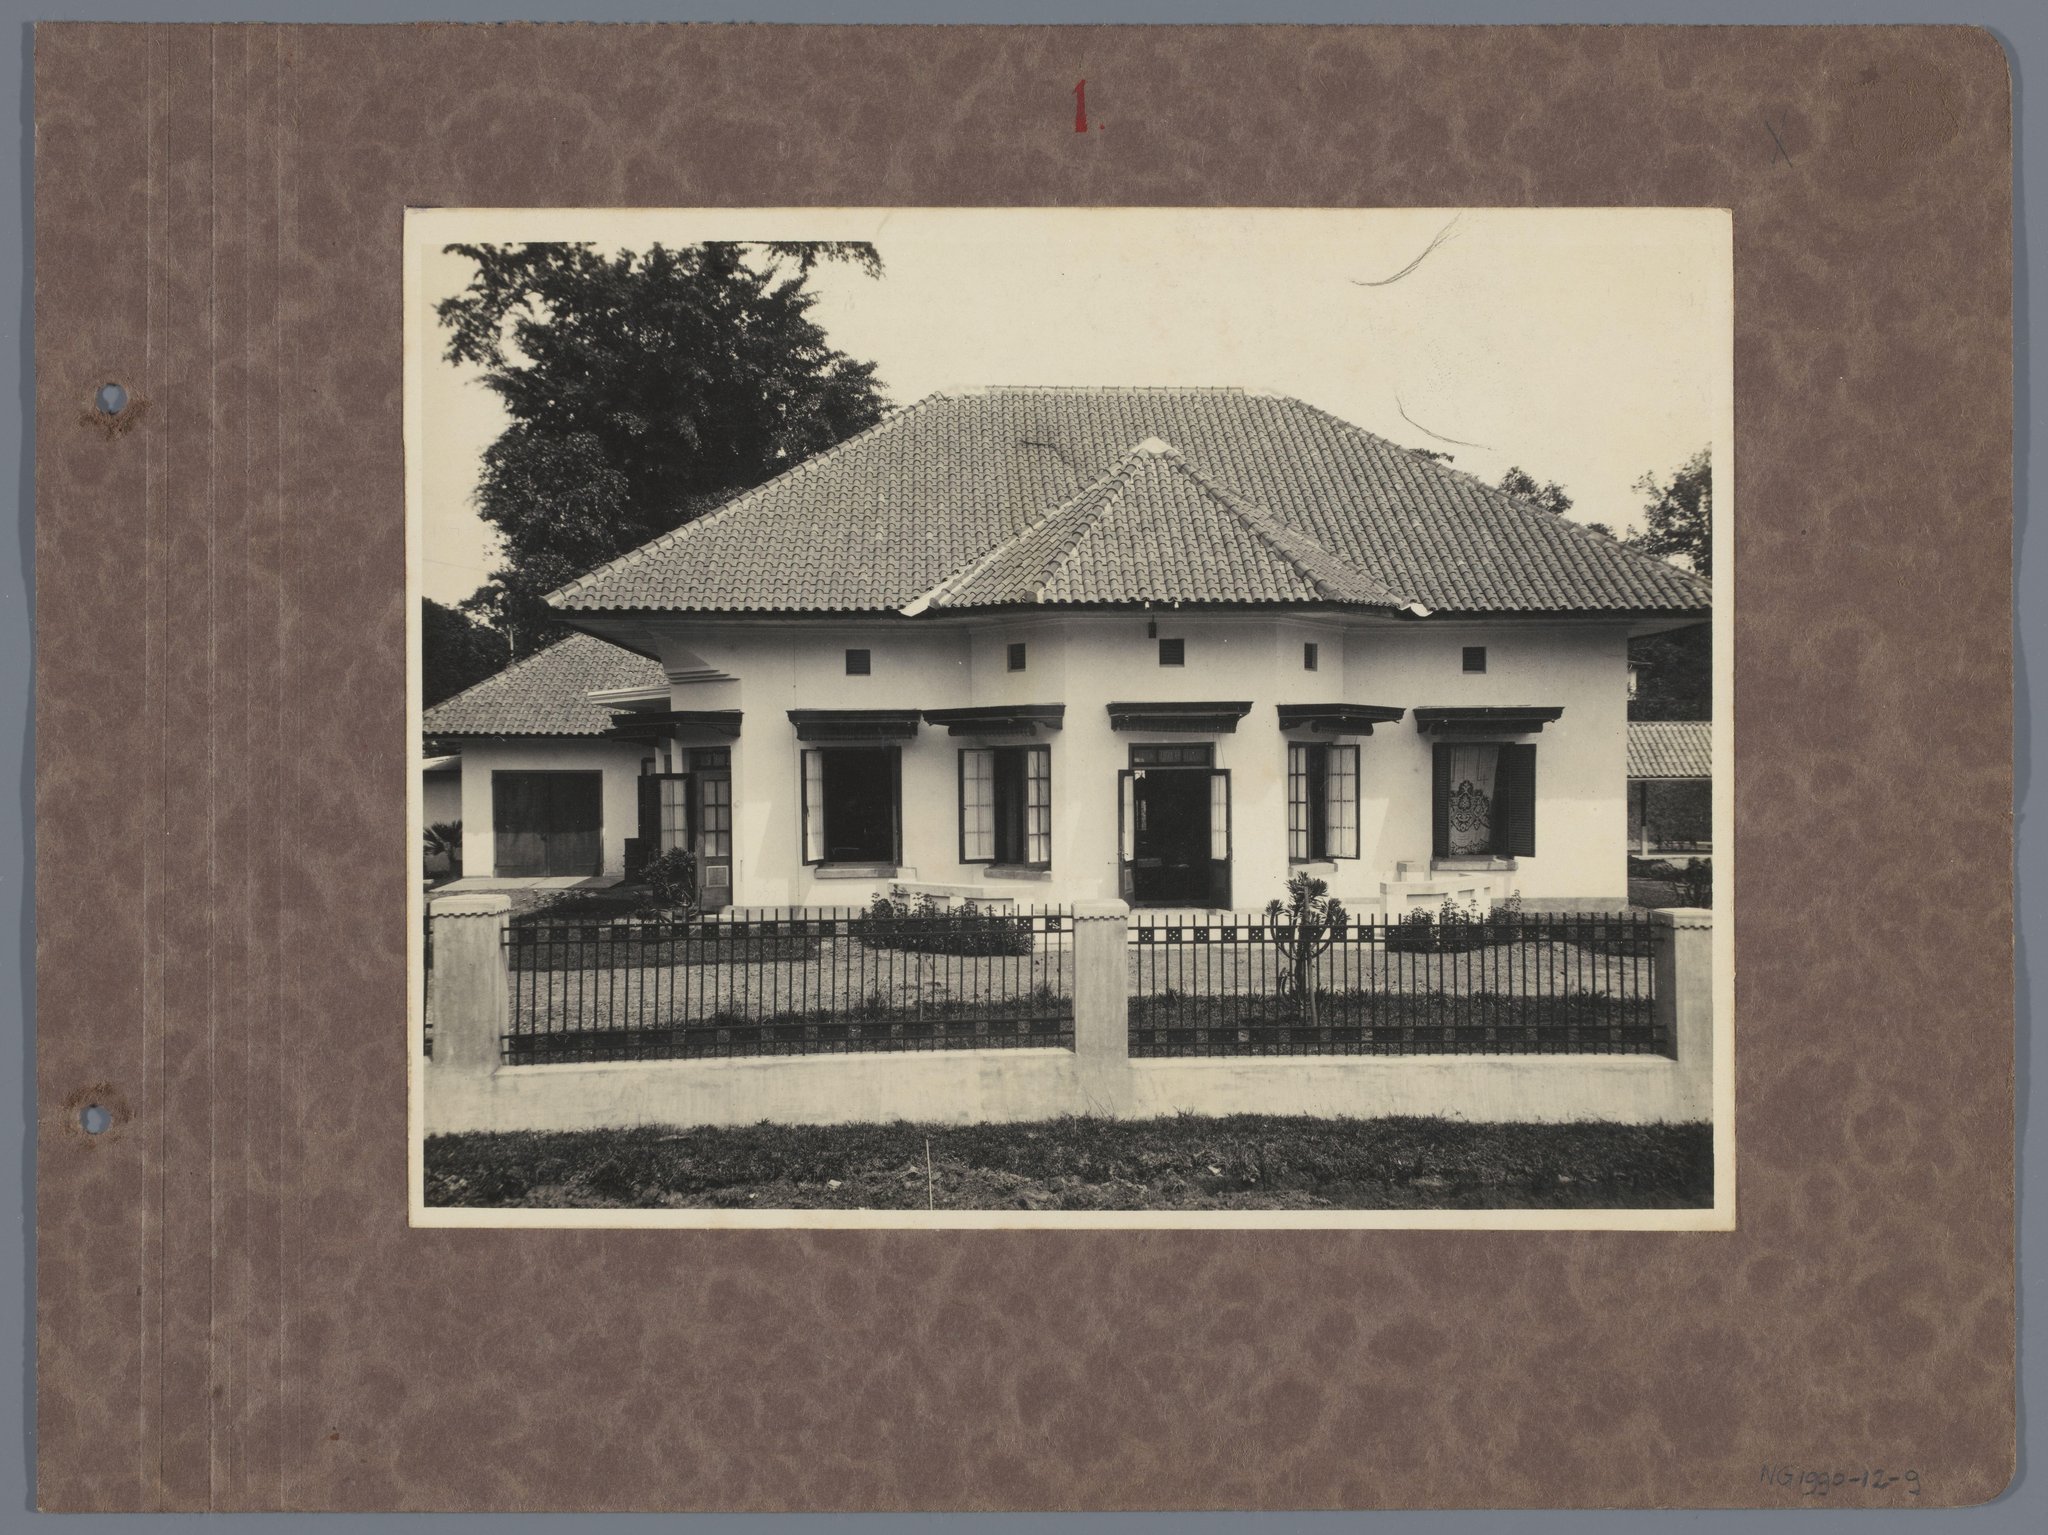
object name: photograph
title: Woonhuis met hek en tuin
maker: Anonymous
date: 1900-1940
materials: cardboard, photographic support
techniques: gelatin silver print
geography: sumatra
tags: sumatra, dutch east indies, the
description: Gezicht op een woonhuis met hek en tuin. Foto opgeplakt op een albumblad genomen uit een fotoalbum. Onderdeel van een groep van 14 losse foto's genomen op Midden- en Zuid-Sumatra in de periode ca. 1900-1940.